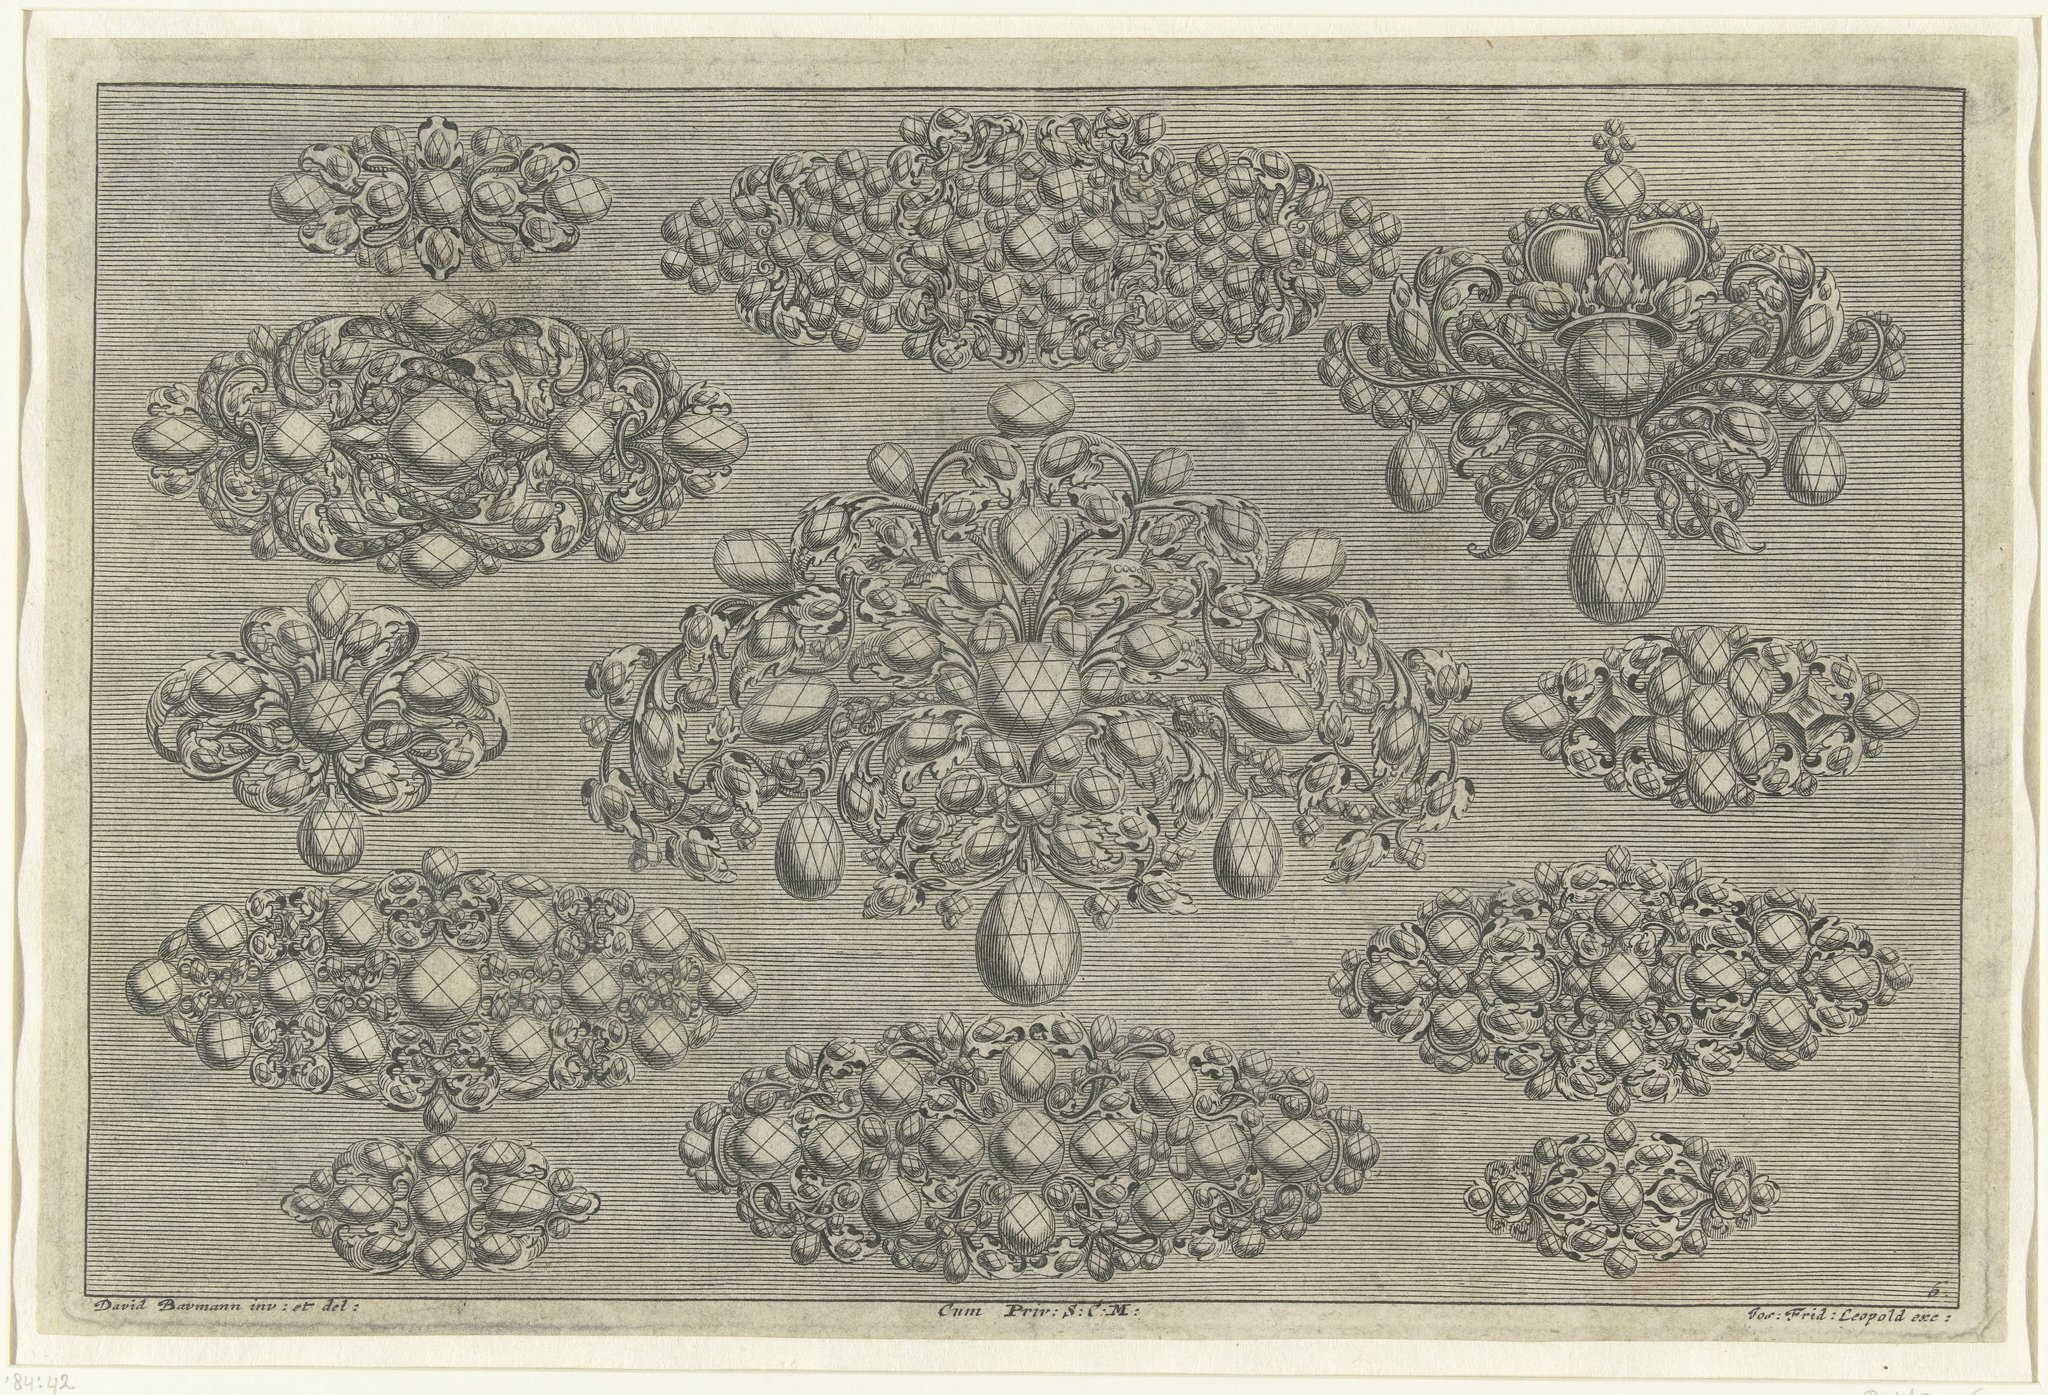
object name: print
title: Twaalf ontwerpen voor juwelen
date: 1695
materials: paper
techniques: engraving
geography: germany